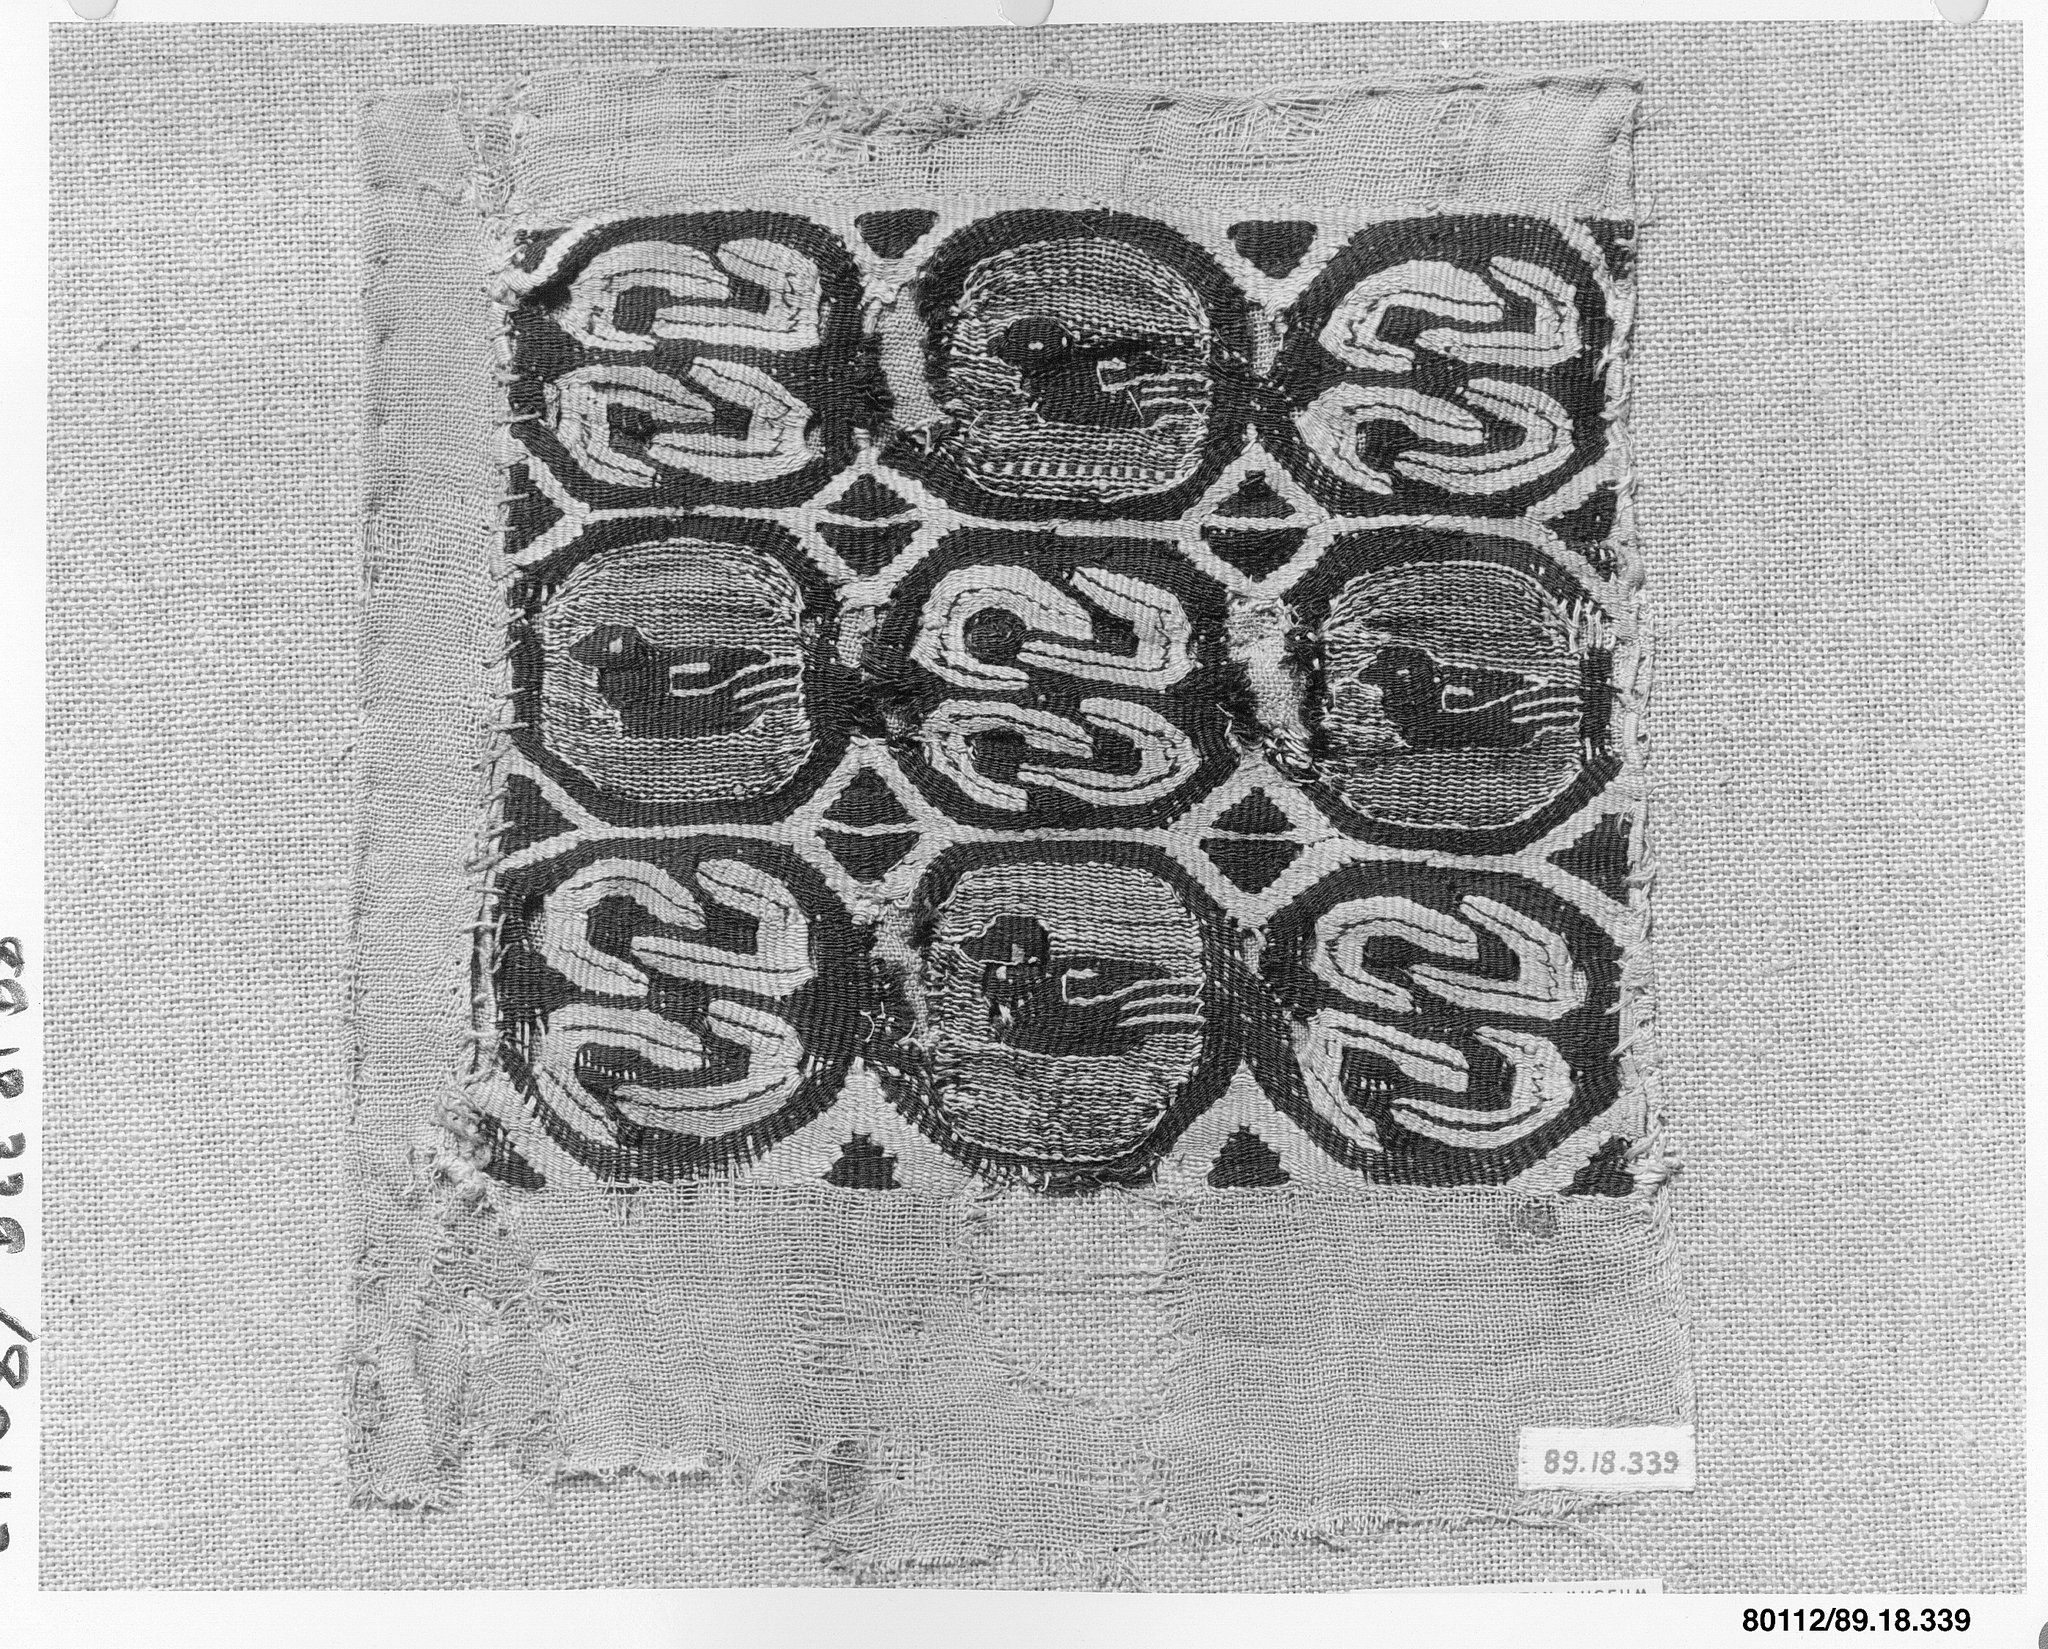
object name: textile fragment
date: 301-400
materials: linen, wool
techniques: weave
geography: egypt